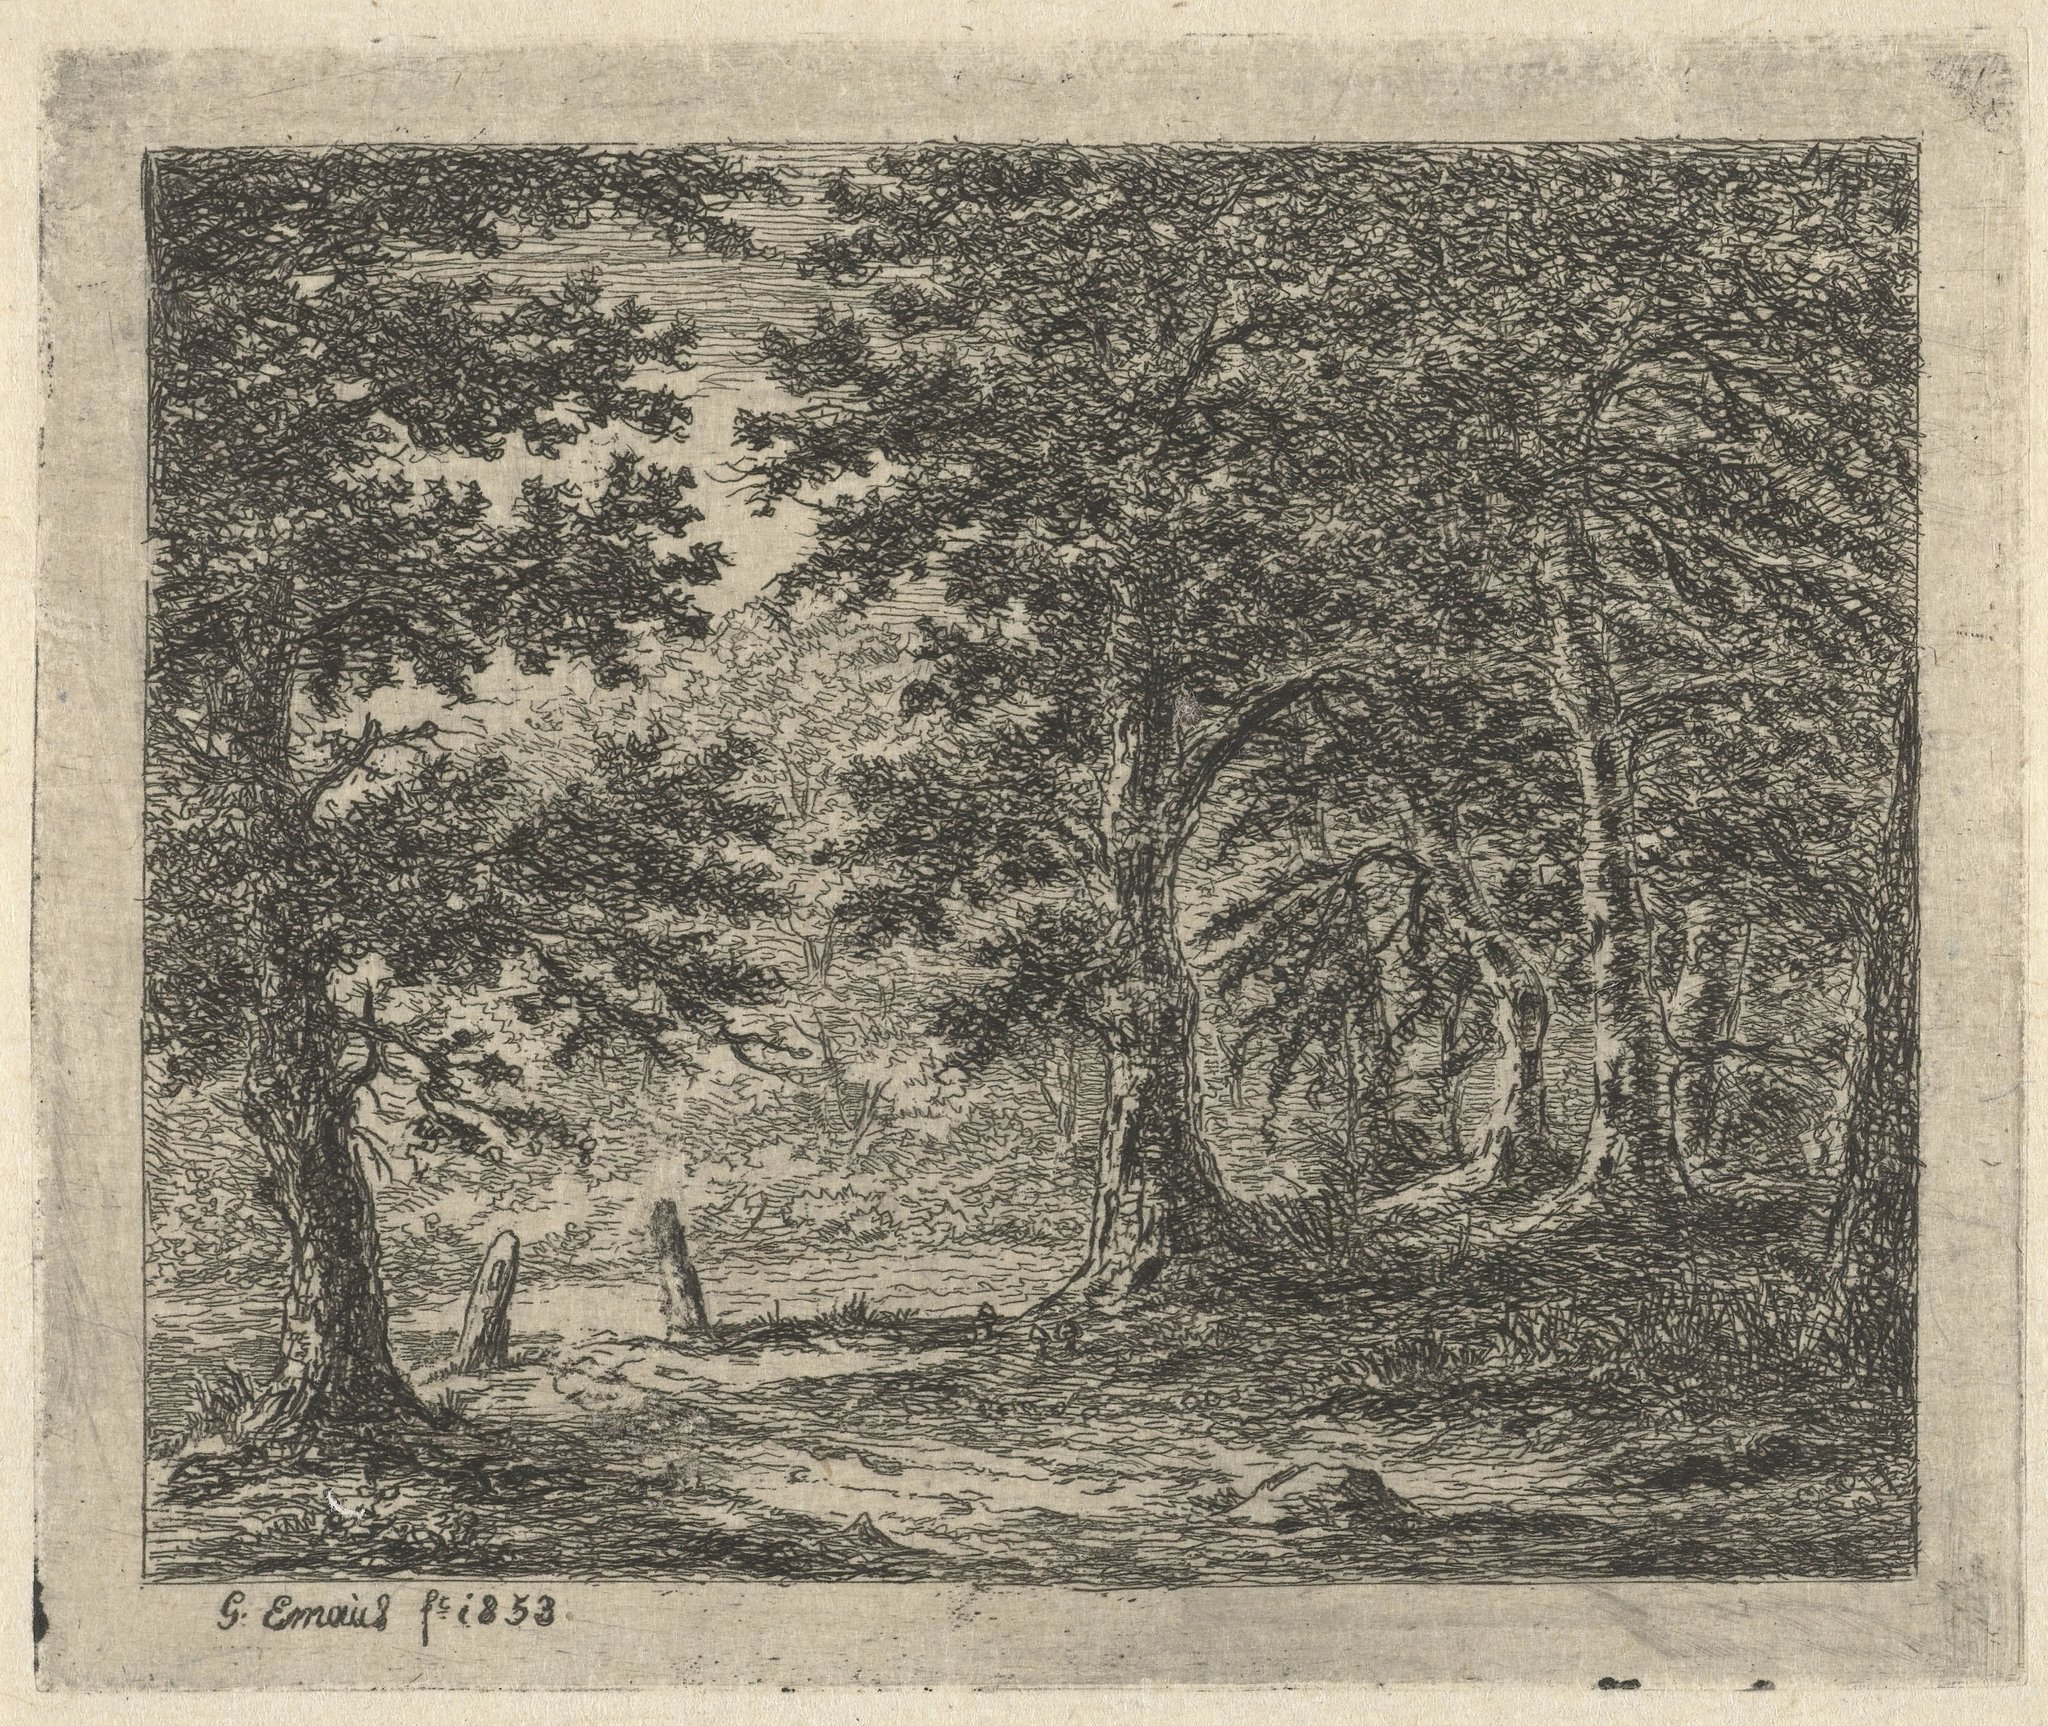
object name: print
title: Open plek in het bos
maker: gerardus emaus de micault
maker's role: draughtsman, print maker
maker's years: 1798-1863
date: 1853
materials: paper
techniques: etching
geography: netherlands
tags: clearing ~ forest (+ outdoors; in the open air)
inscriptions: date